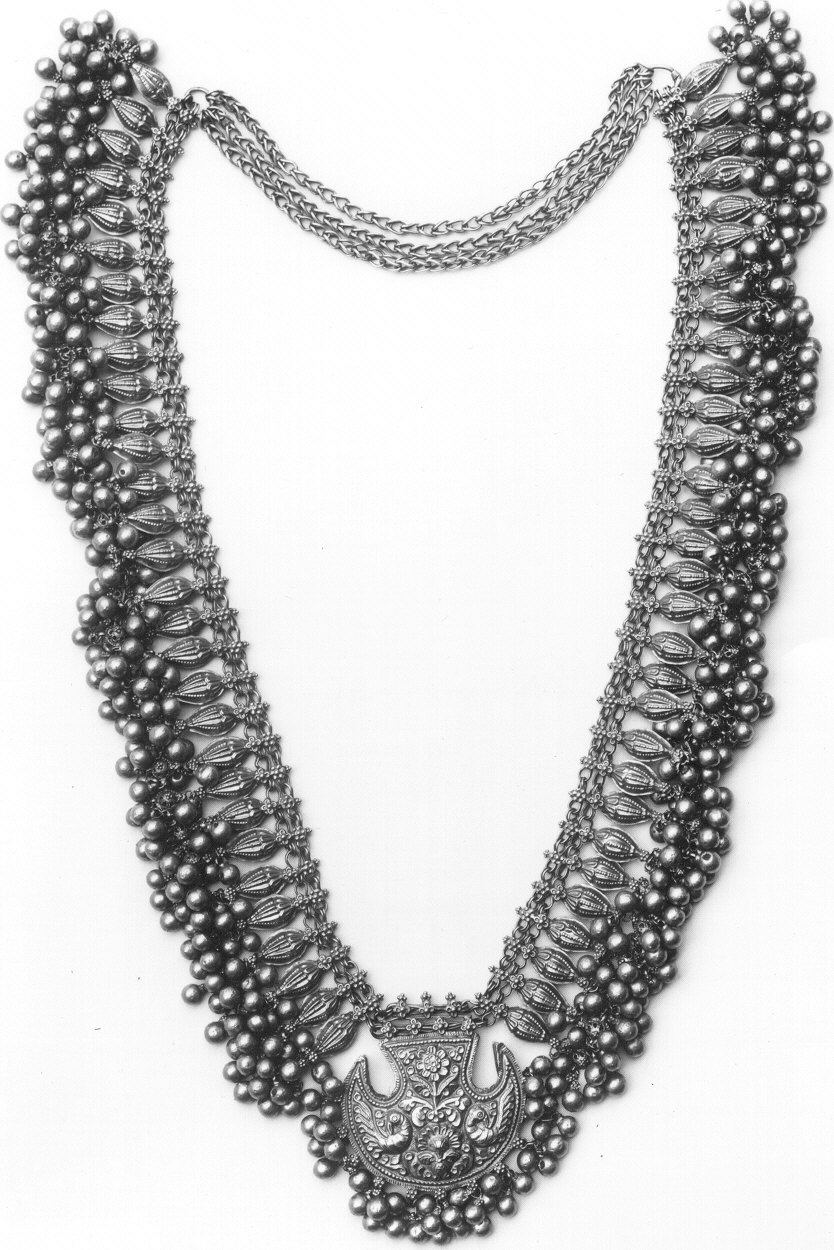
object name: necklace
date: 1701-1800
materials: gold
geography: india